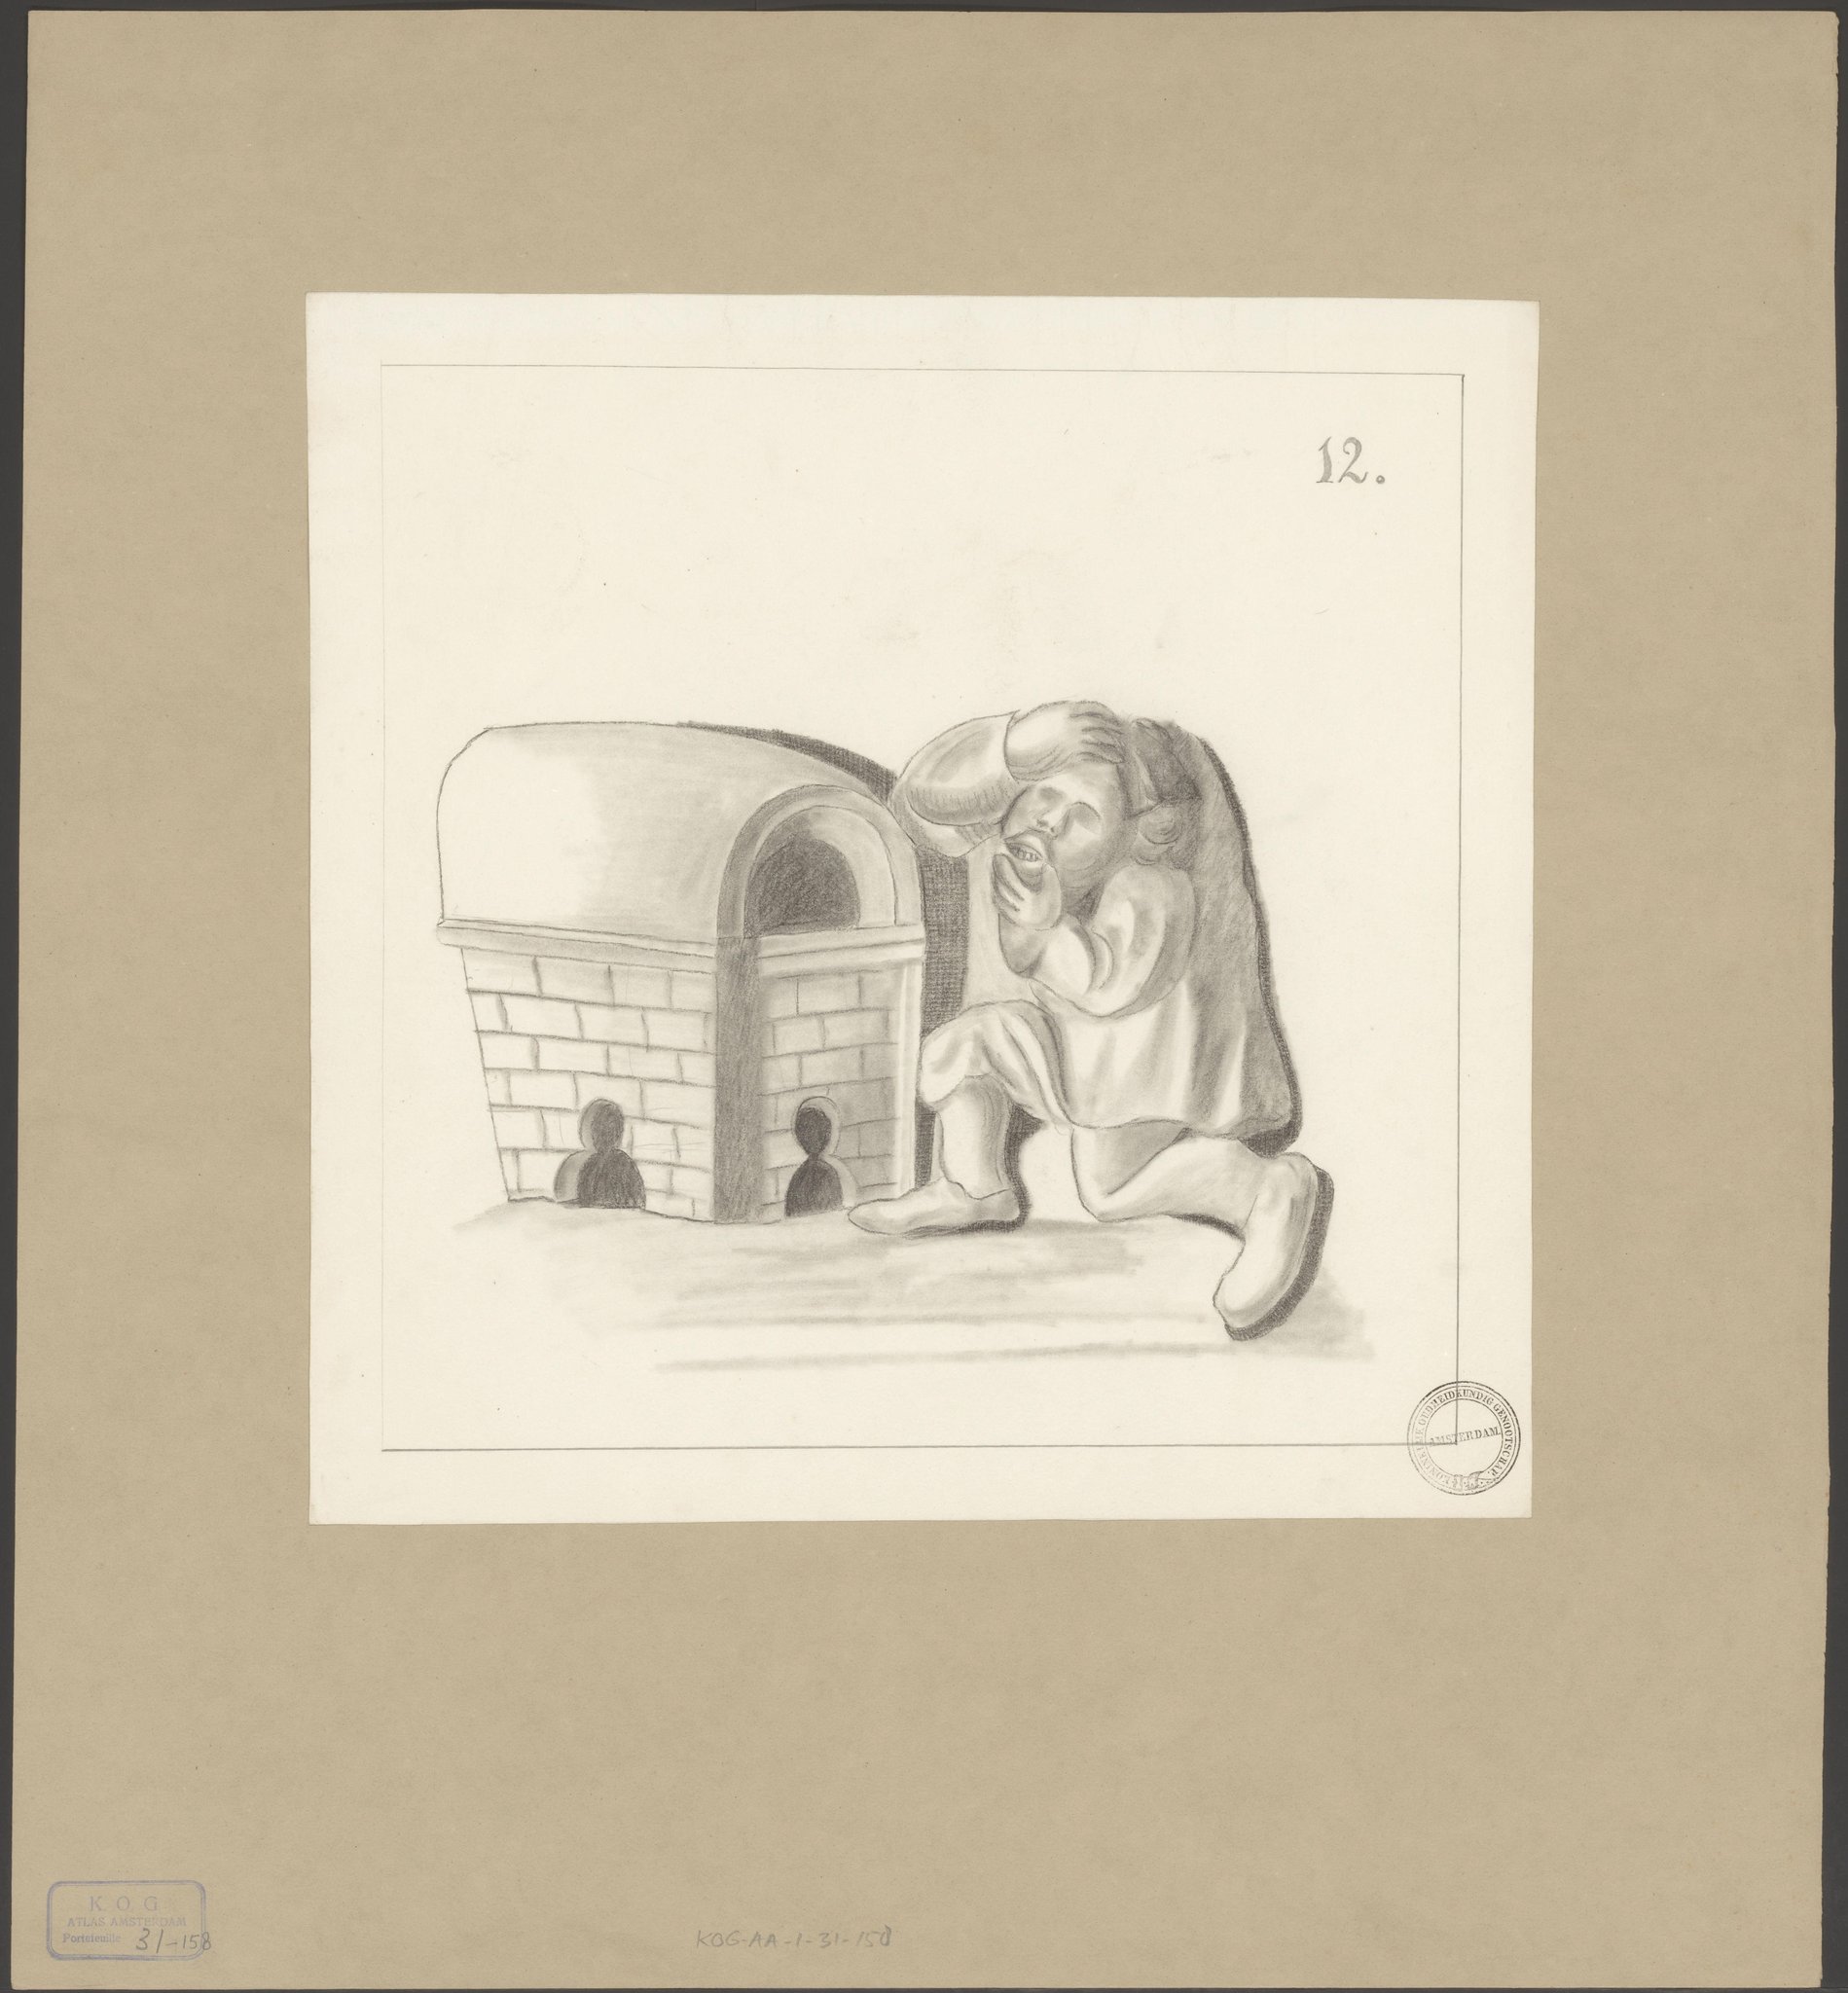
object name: print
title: Misericorde met hurkende man naast een oven in de Oude Kerk te Amsterdam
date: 1880-1929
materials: paper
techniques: lithograph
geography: amsterdam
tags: misericords, fire, oven, furnace ~ interior of industrial structure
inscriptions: collector's mark: ‘Koninklijk Oudheidkundig Genootschap / Amsterdam’, collector's mark: ‘31-158’ Lugt 1641b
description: Rechtsboven genummerd: 12. Onderwerpsrubriek binnen de Atlas Amsterdam: Kerkwezen: Hervormde Gemeente: Oude Kerk, koorgestoelte.